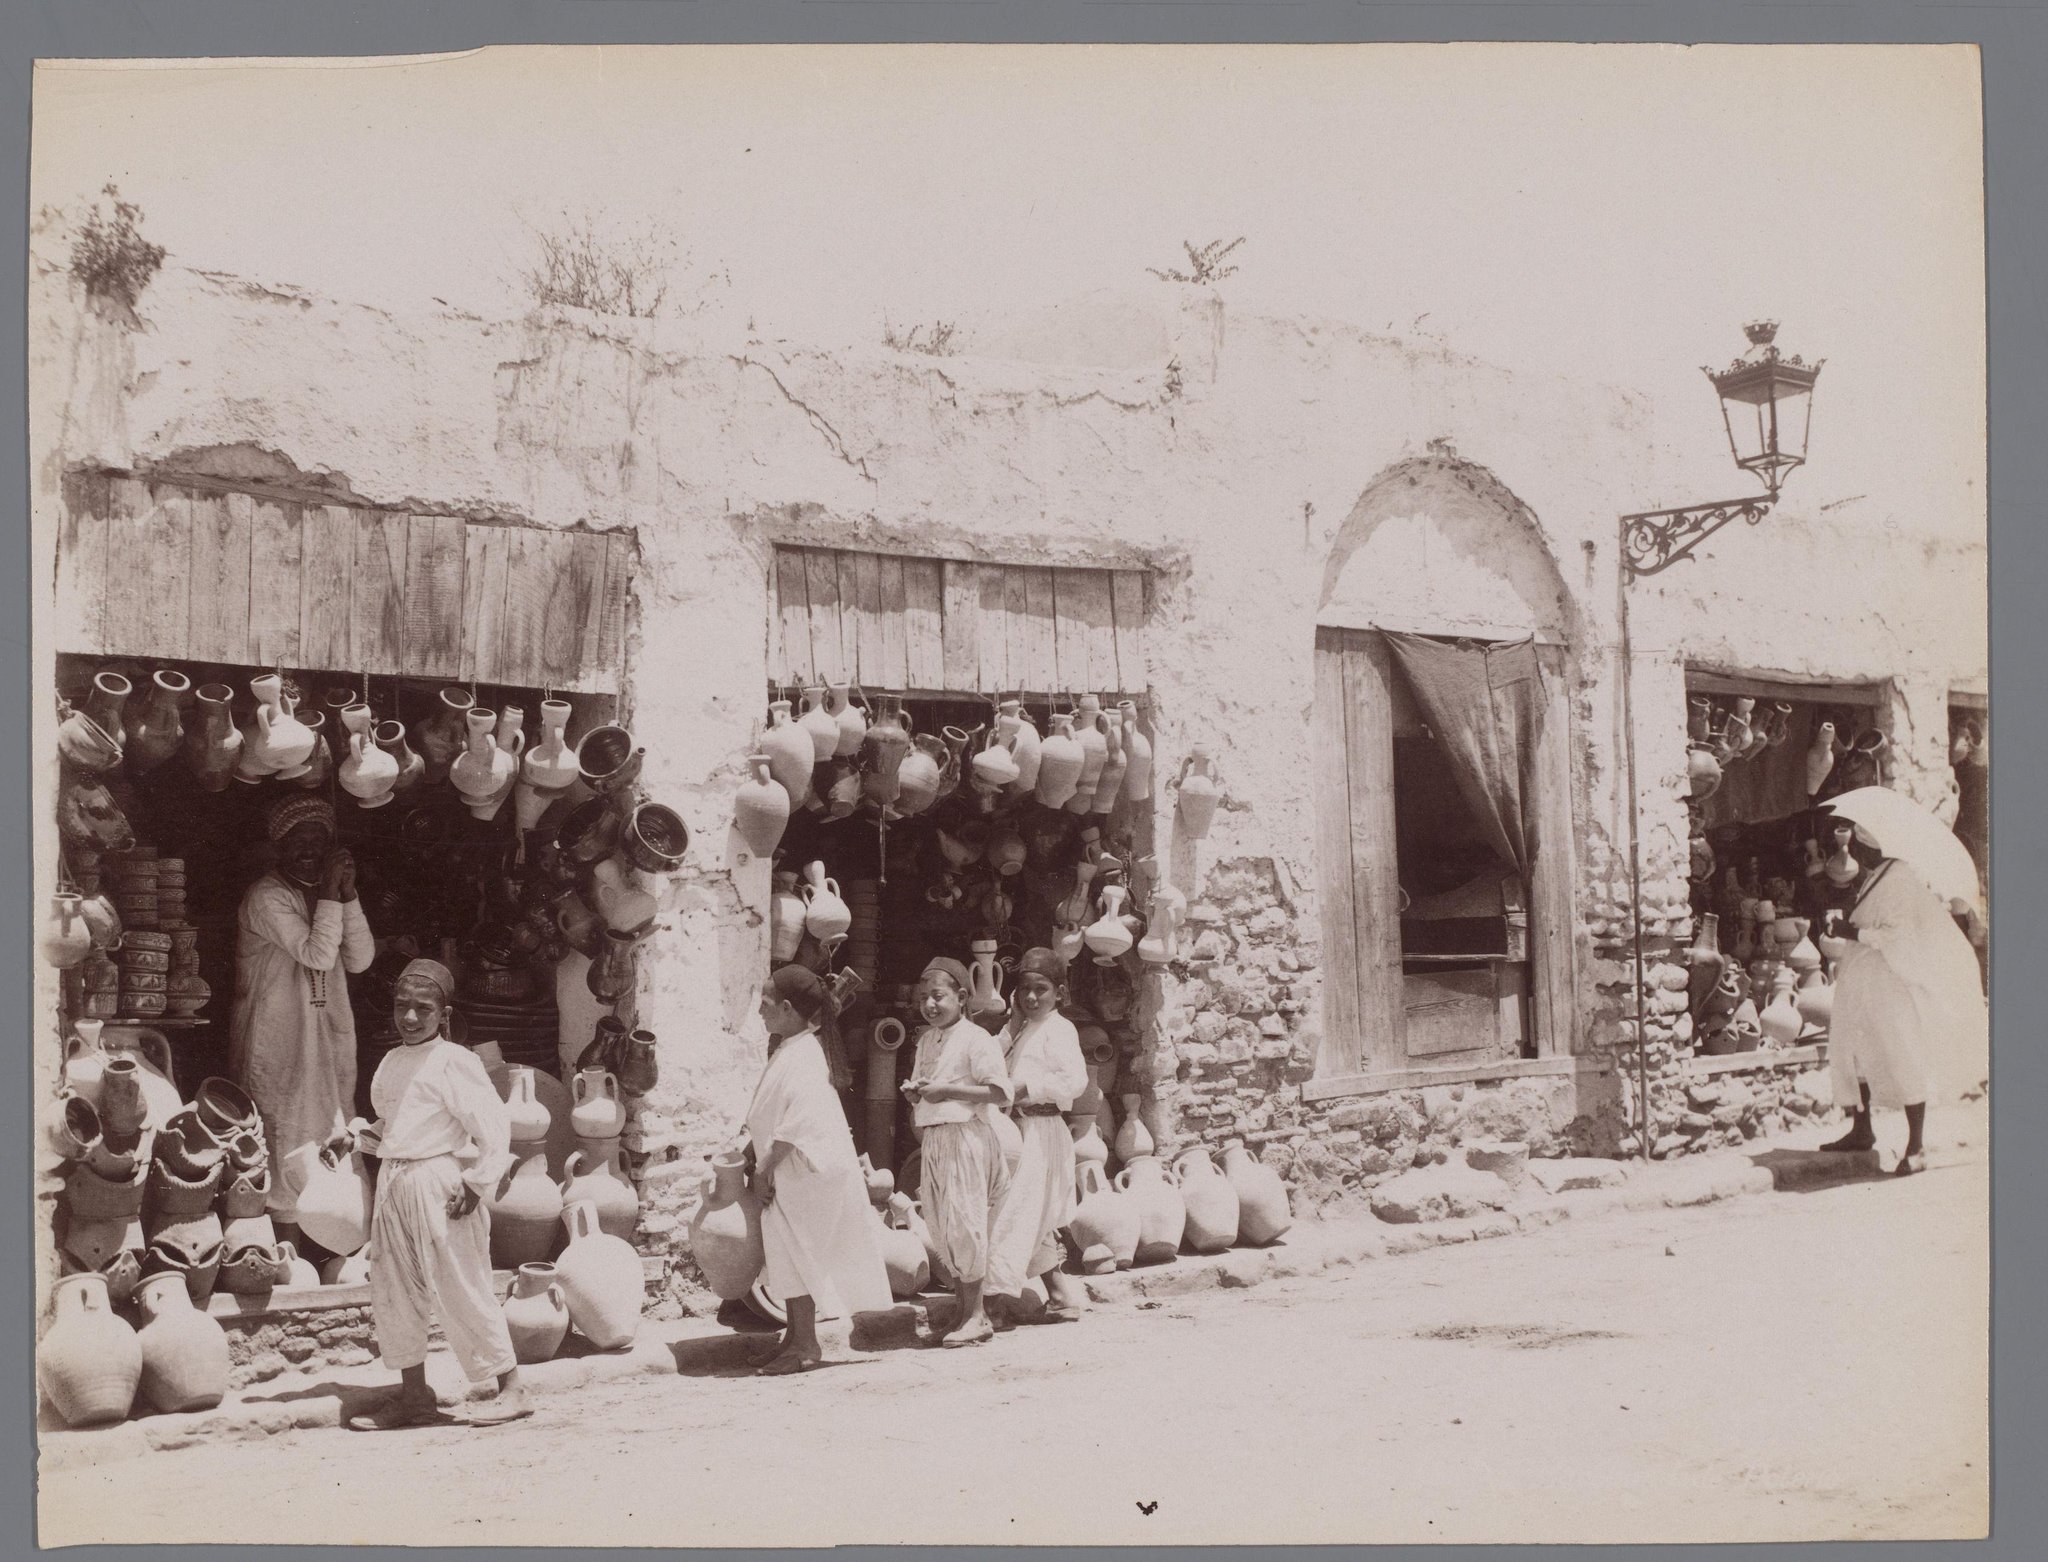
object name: photograph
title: Gezicht op een kruikenwinkel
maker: Anonymous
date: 1860-1900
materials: paper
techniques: albumen print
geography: middle east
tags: shop, store, container of ceramics: jar, jug, pot, vase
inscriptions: inscription: ‘[onleesbaar]’